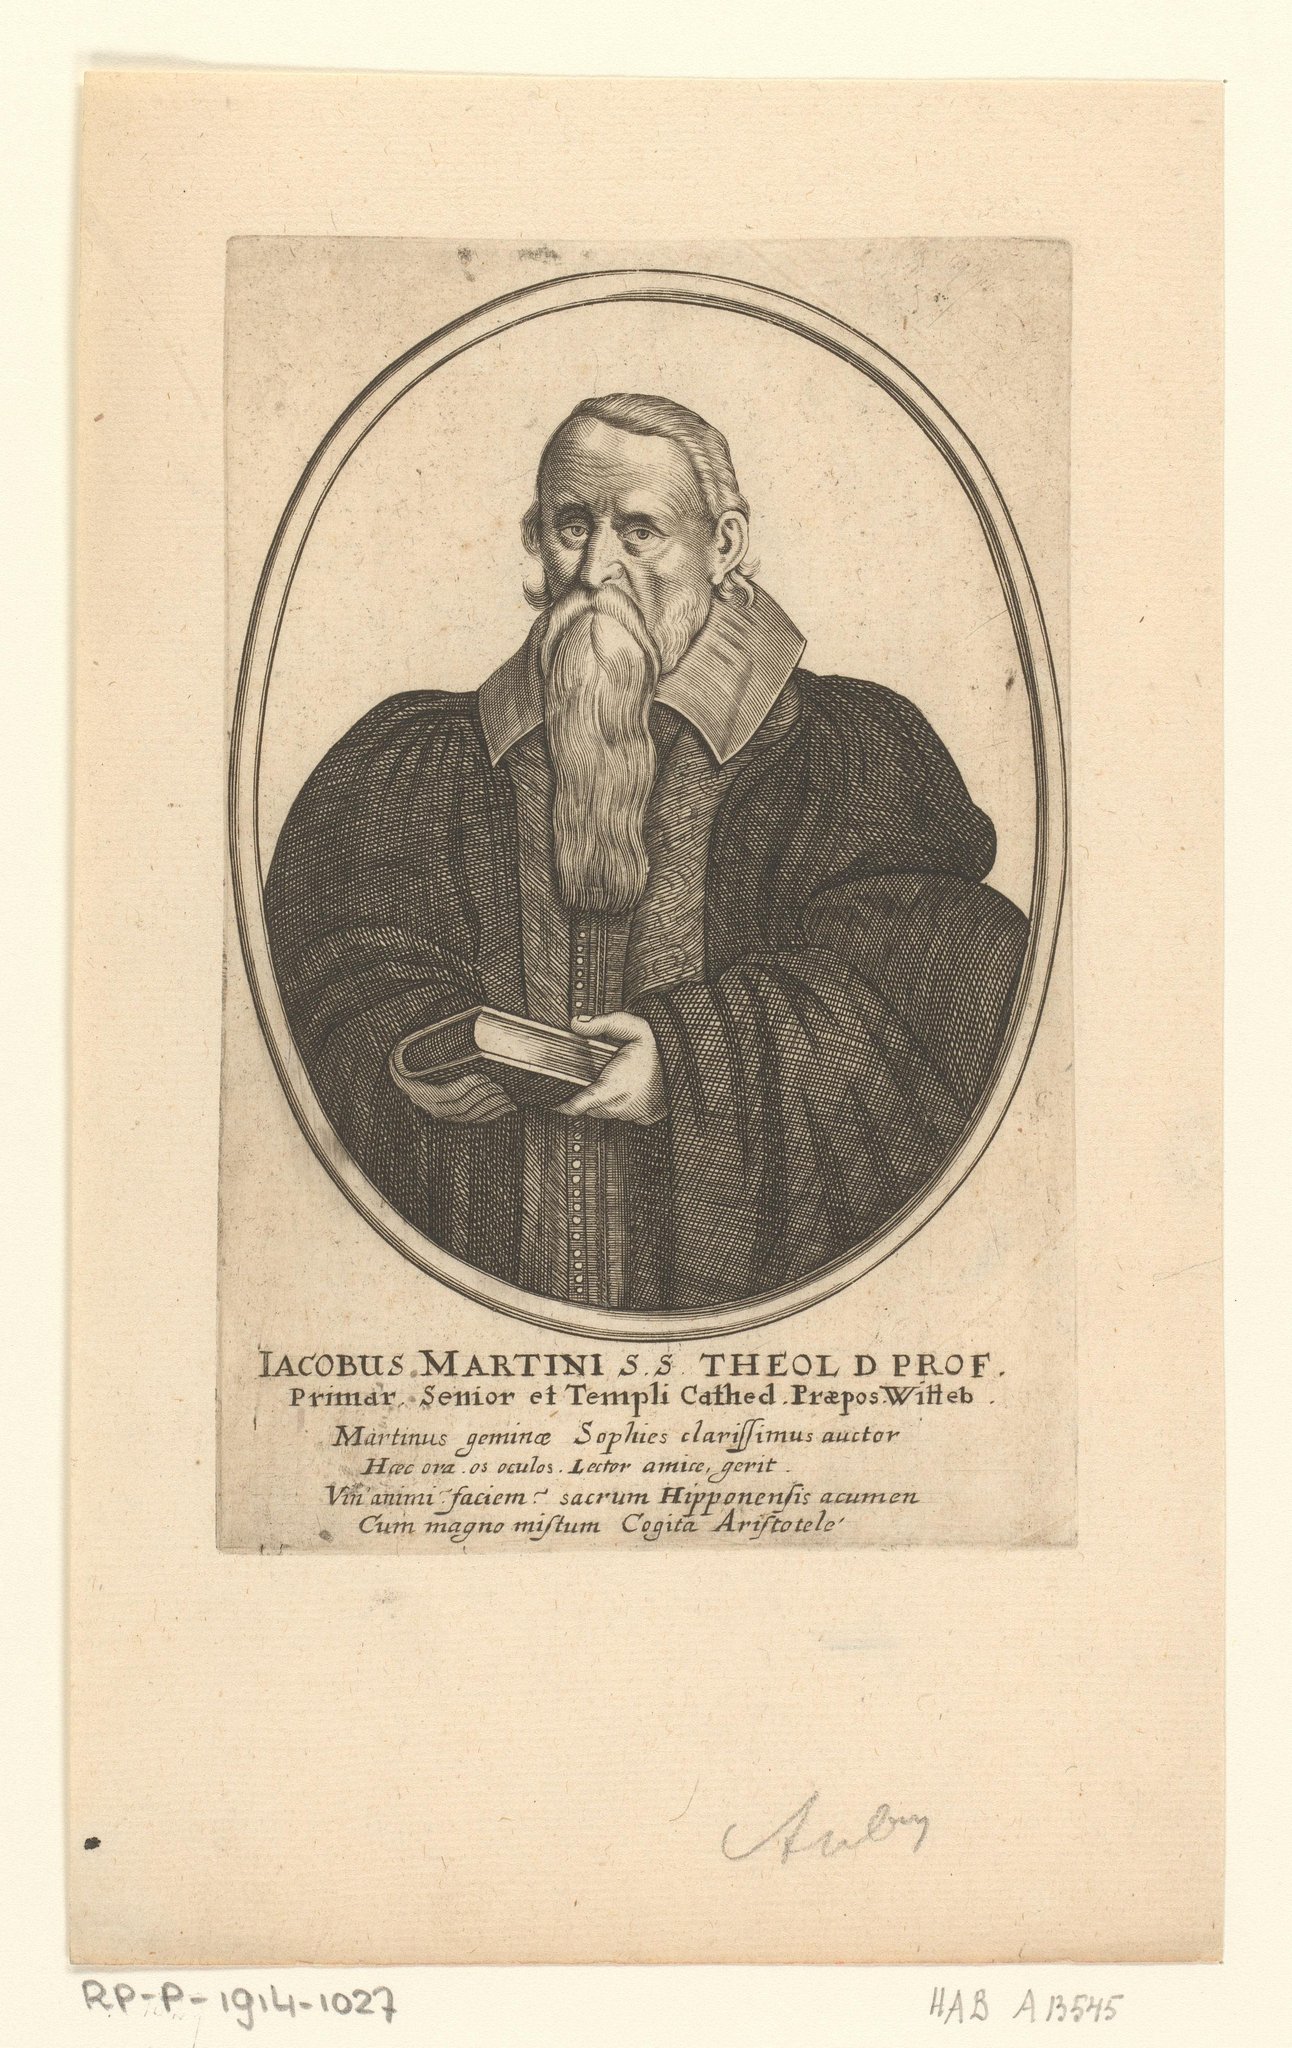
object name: print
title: Portret van Jakob Martini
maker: peter aubry (ii)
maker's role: print maker, publisher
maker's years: 1596-1668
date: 1620-1686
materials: paper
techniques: engraving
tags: theologian, scholar, philosopher, historical persons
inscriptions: collector's mark: Lugt 2228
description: Met zesregelig onderschrift in het Latijn.